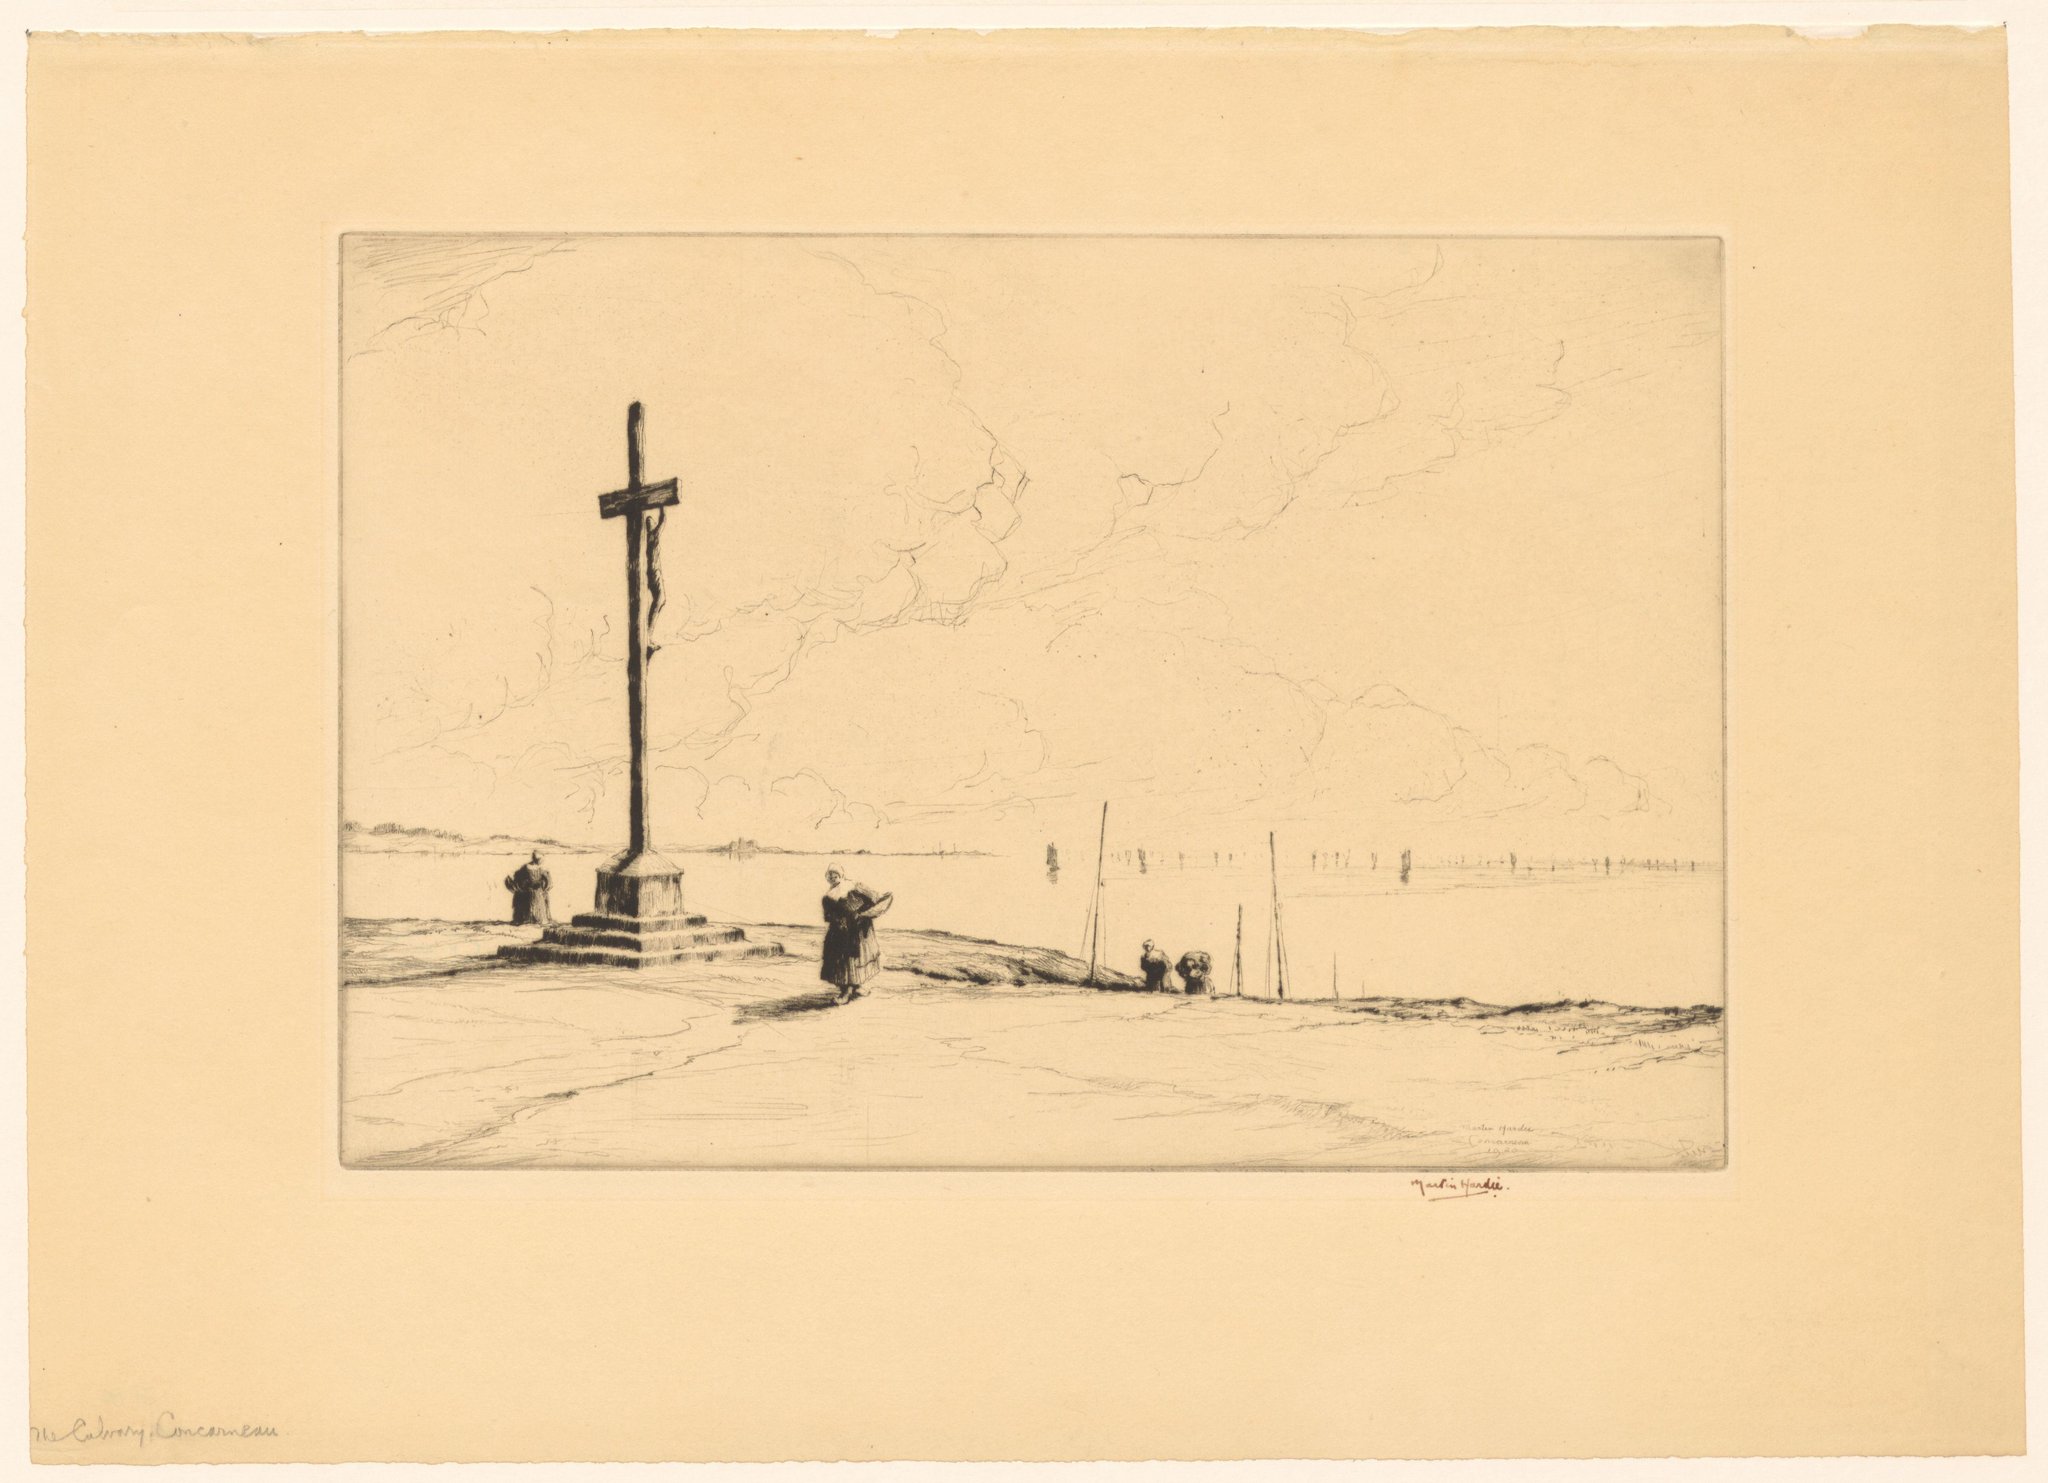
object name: print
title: Kruisbeeld aan de kust bij Concarneau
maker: martin hardie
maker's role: print maker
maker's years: 1875-1952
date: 1920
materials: paper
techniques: drypoint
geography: concarneau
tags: altarcross, crucifix, coast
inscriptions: collector's mark: Lugt 2228, collector's mark: Lugt 2760, annotation: ‘Martin Hardie’